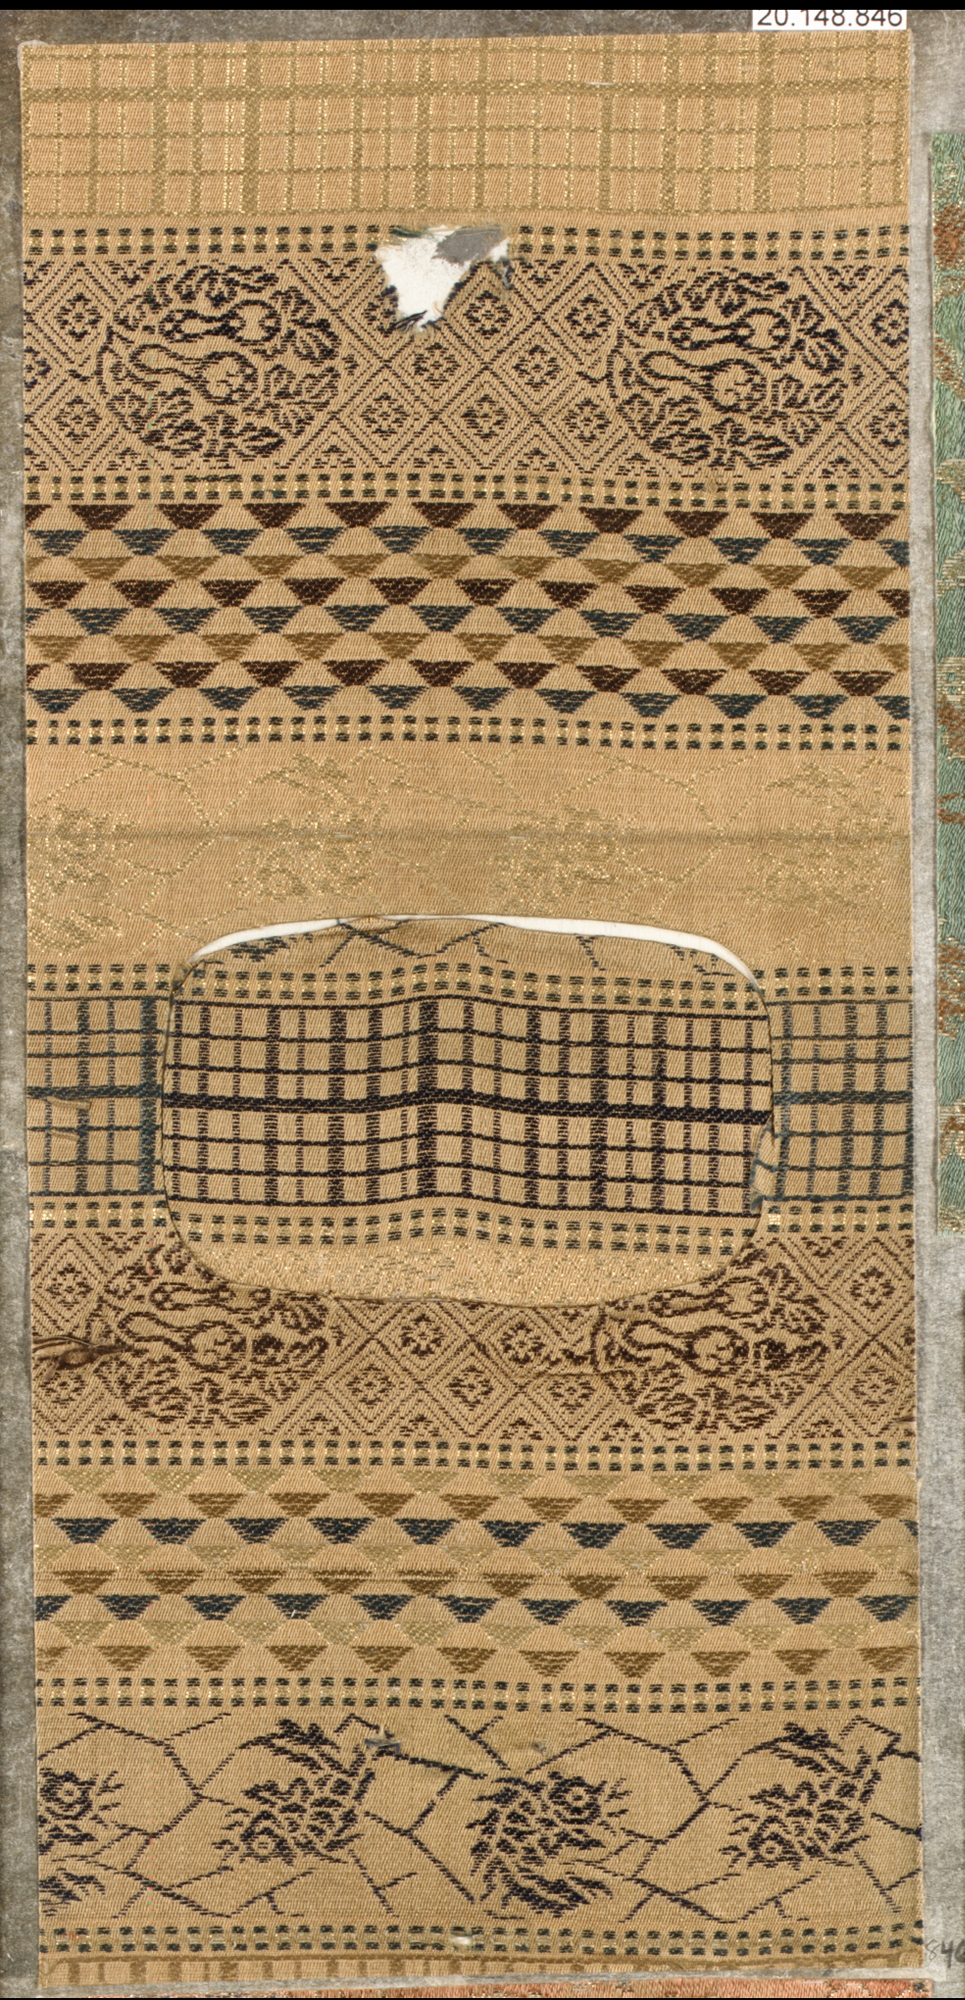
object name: piece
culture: japanese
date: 1601-1700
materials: silk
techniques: compound weave